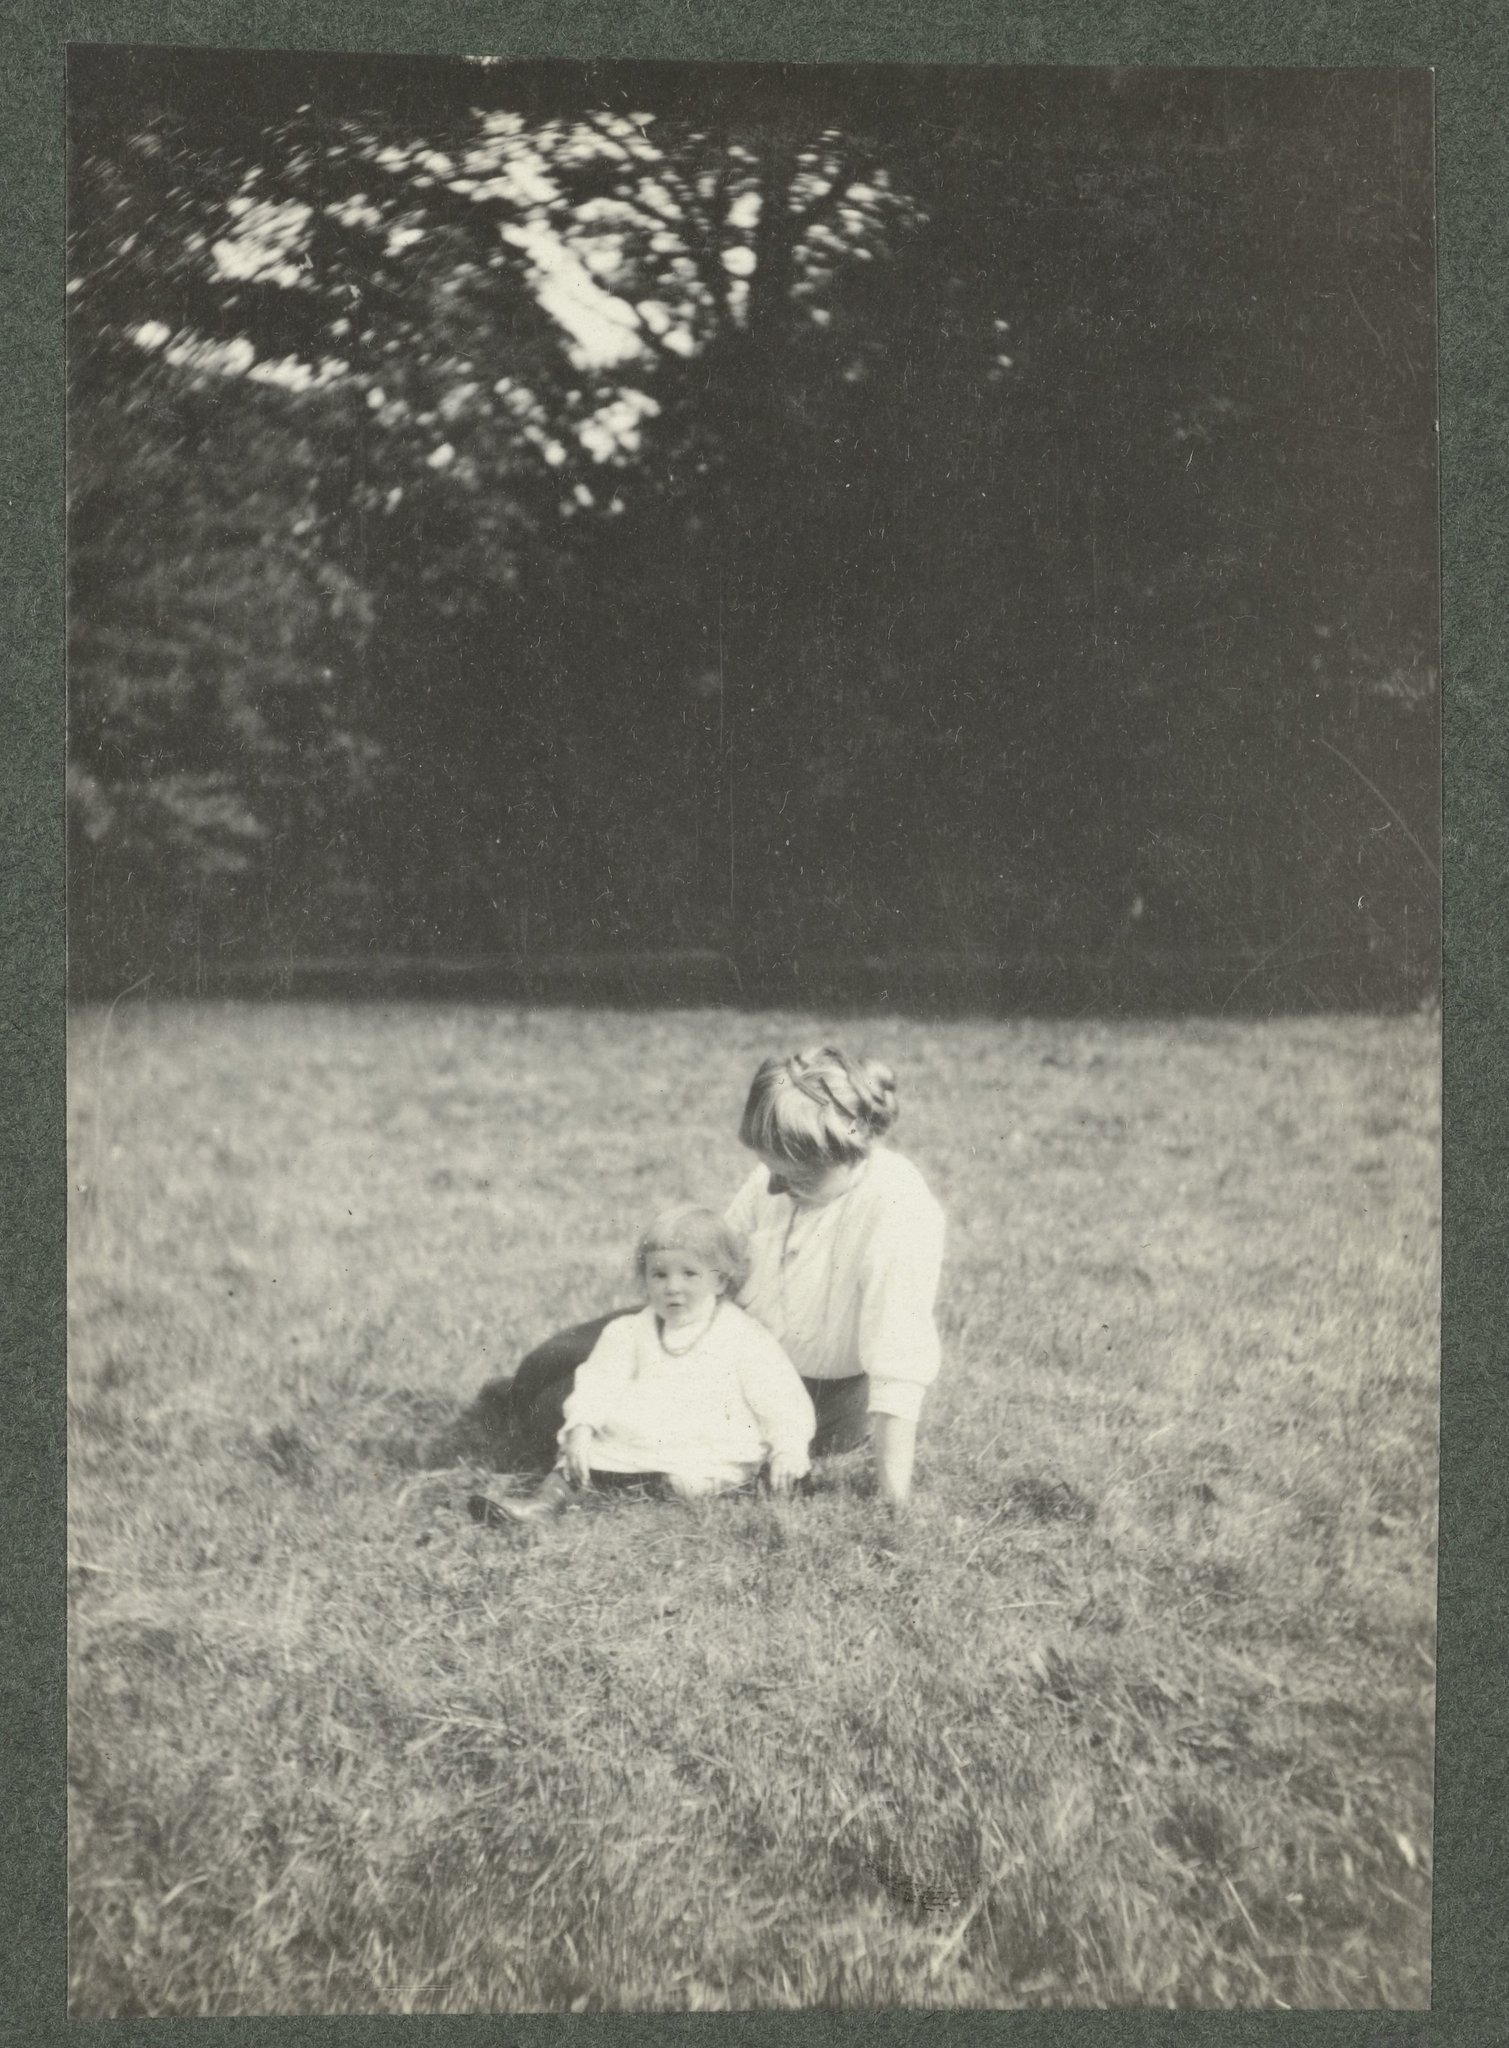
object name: photograph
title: Moeder en dochter zitten op het gras, Landgoed De Paauw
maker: geldolph adriaan kessler (dolph)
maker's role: fotograaf, industrieel, voetballer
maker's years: 1884-1945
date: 1913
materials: paper, photographic support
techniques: photography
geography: netherlands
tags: huize de paauw